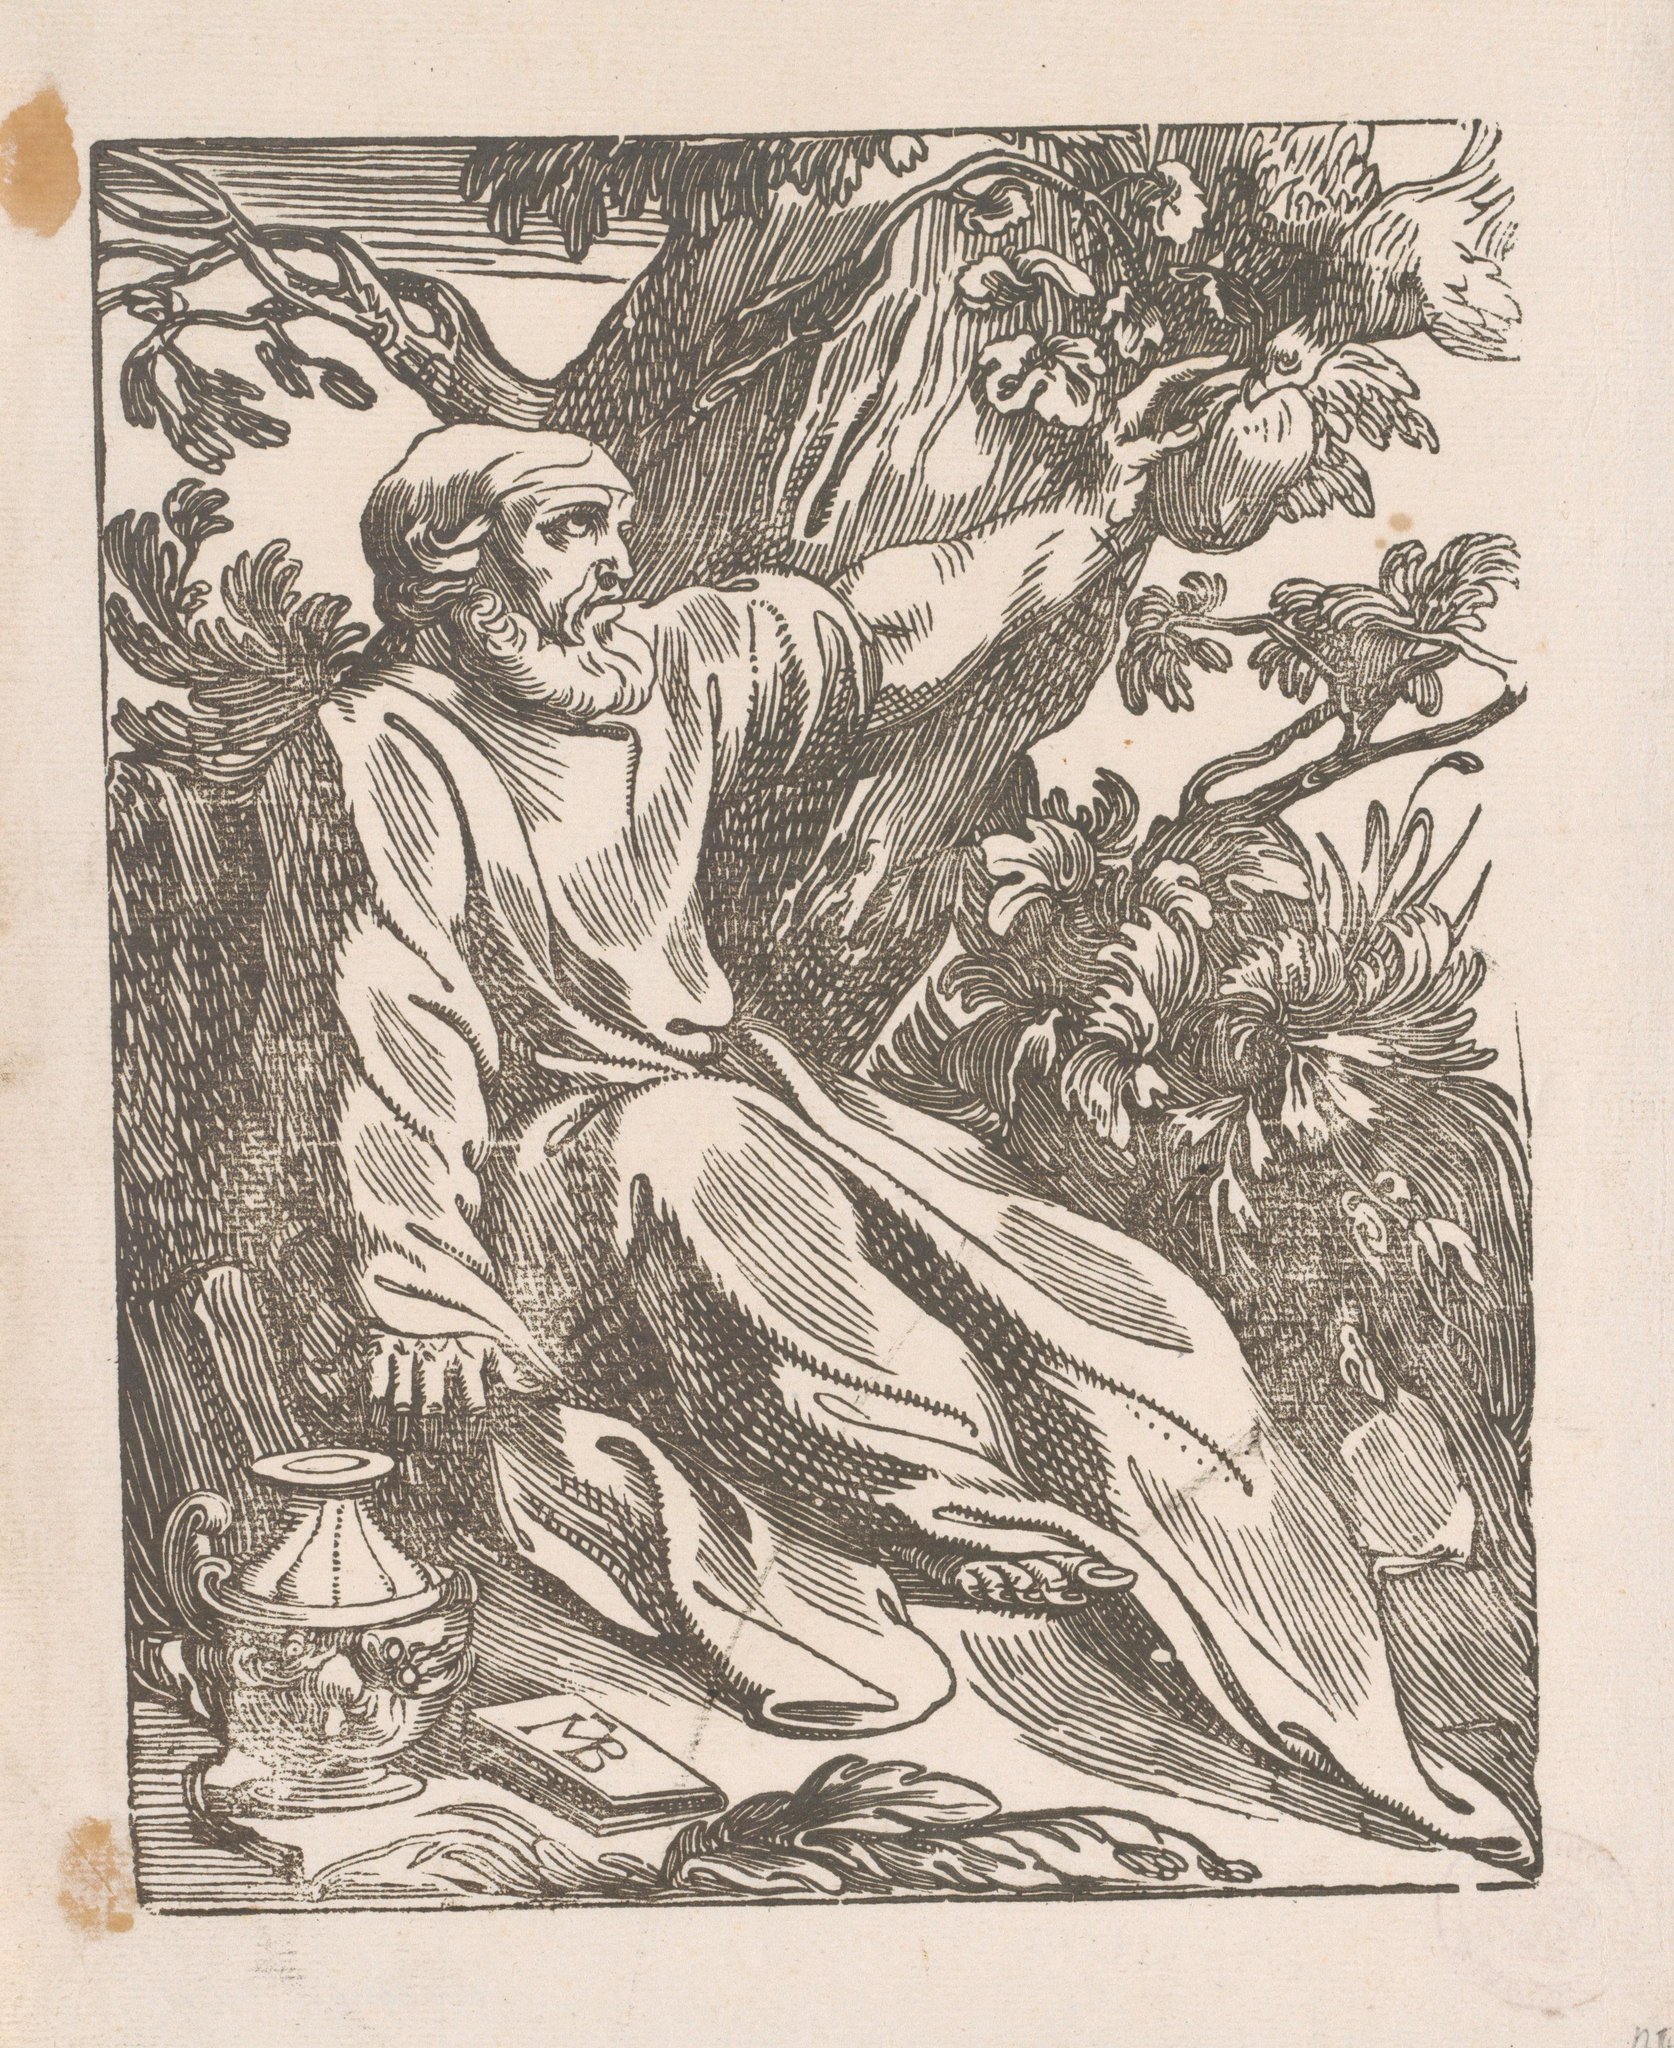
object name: print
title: Elia gevoed door de raven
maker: moyses van wtenbrouck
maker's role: painter, print maker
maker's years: 1590-1647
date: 1615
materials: paper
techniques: woodcut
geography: the hague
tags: elijah fed by the raven(s): while the prophet is living by the brook, ravens bring him food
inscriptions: collector's mark: Lugt 240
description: Elia zit onder een boom bij de beek Kirit waar raven hem brood en vlees komen brengen. Hij steekt zijn arm uit richting een raaf met voedsel in zijn snavel.